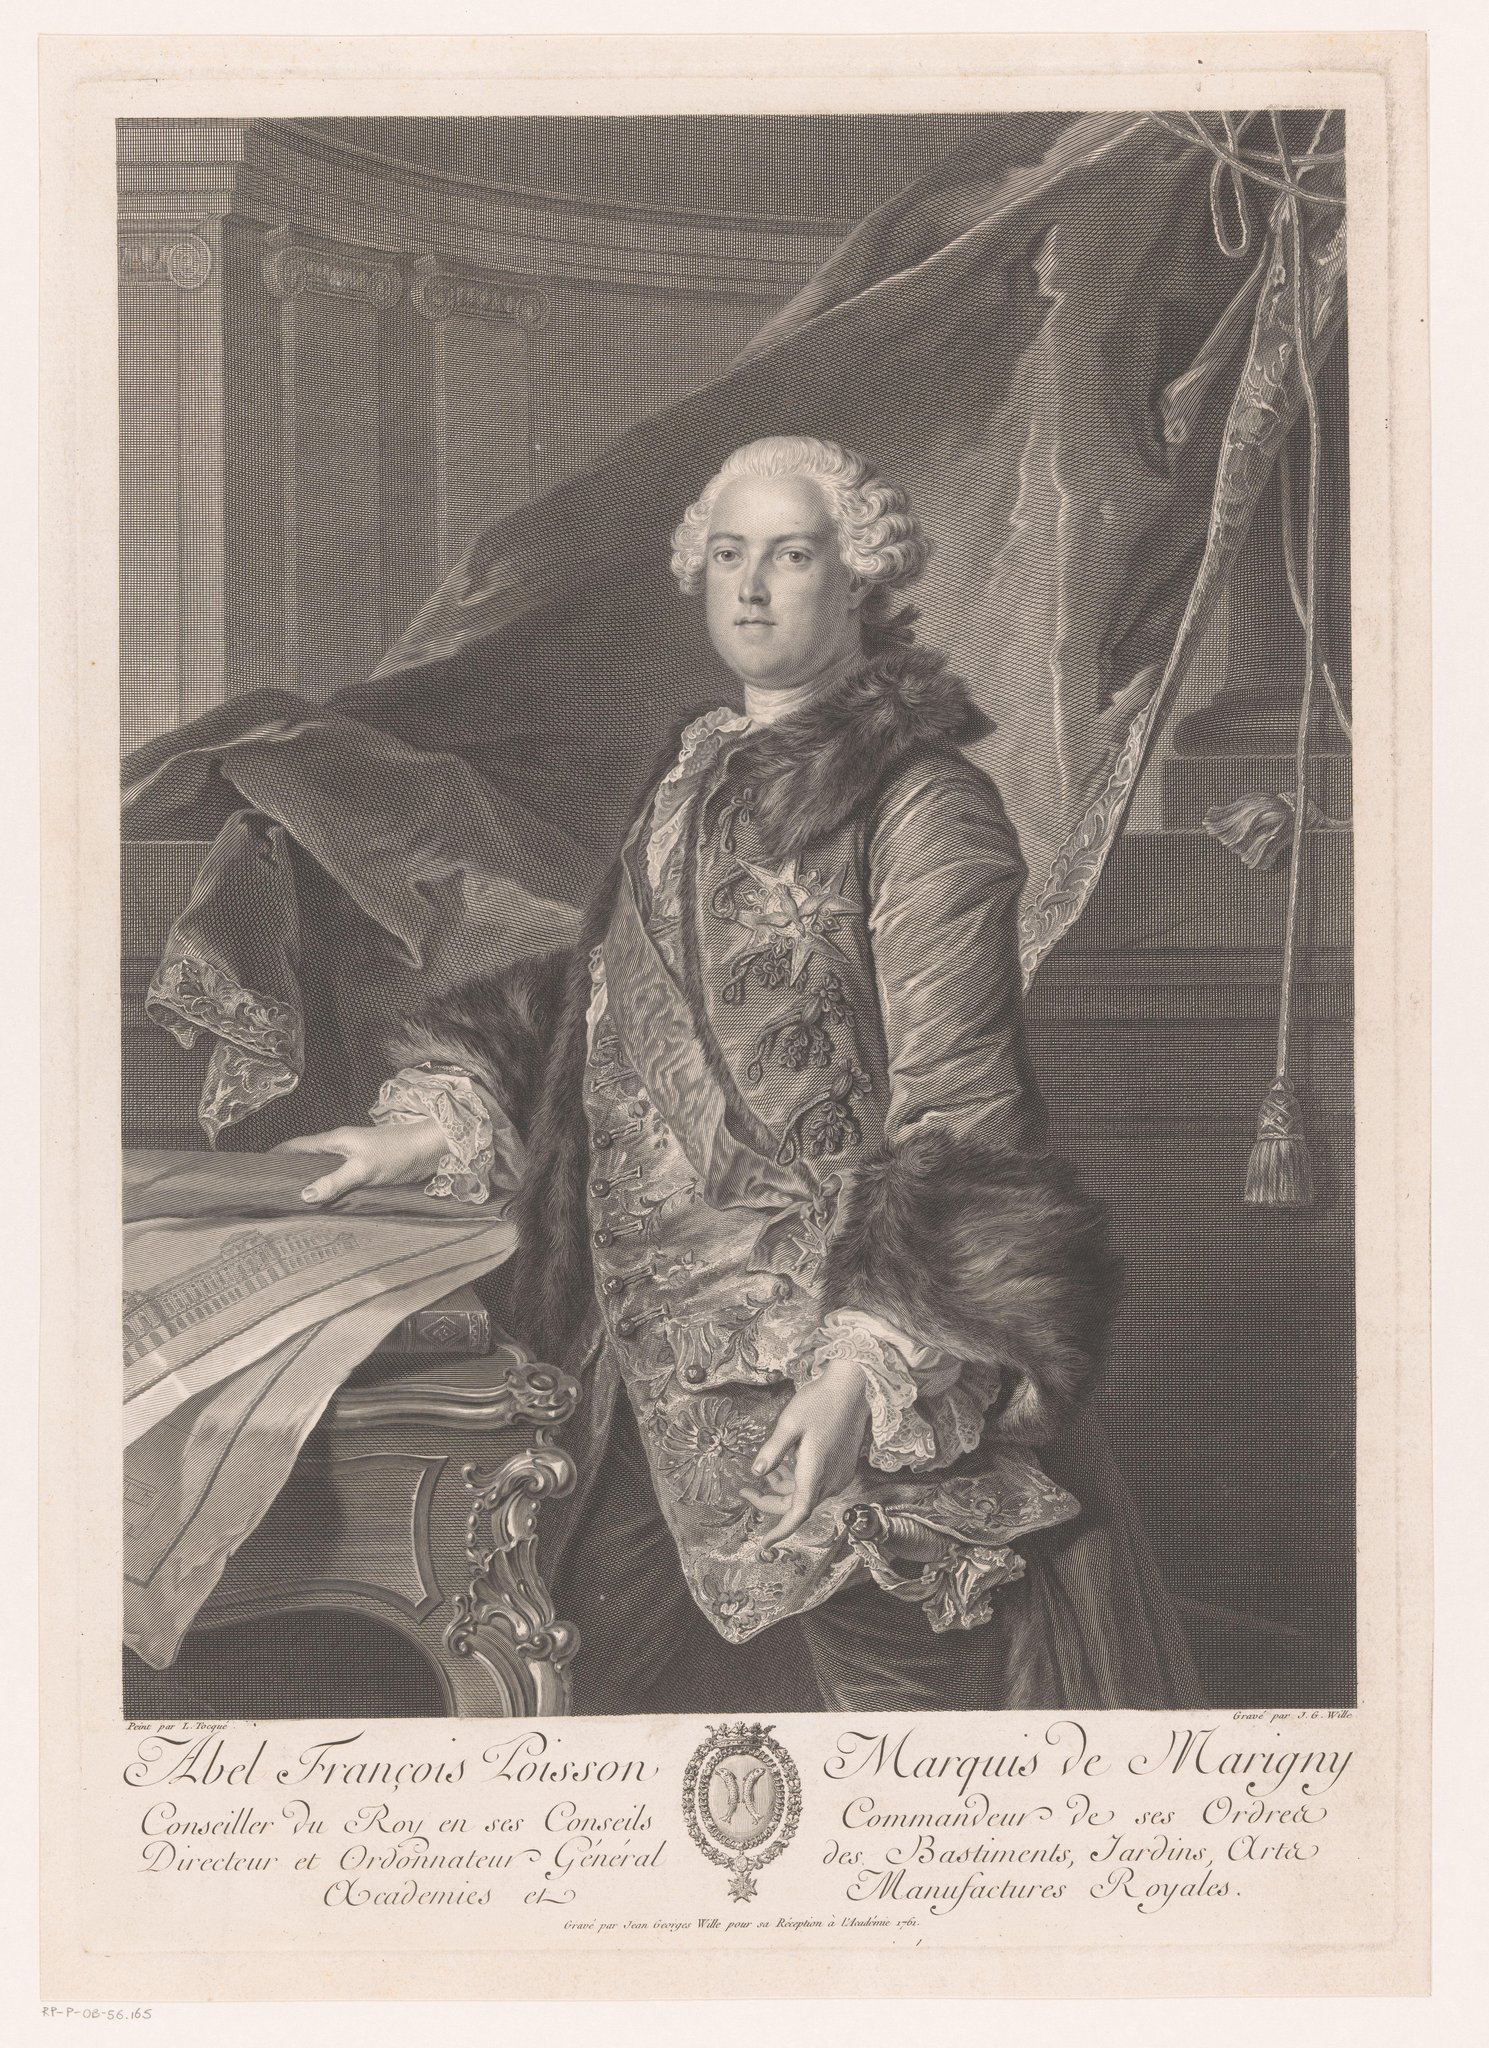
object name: print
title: Portret van Abel François Poisson, marquis de Marigny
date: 1761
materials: paper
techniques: engraving, etching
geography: france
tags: paris, abel françois poisson de vandières (marquis de marigny), historical persons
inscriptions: collector's mark: Lugt 240